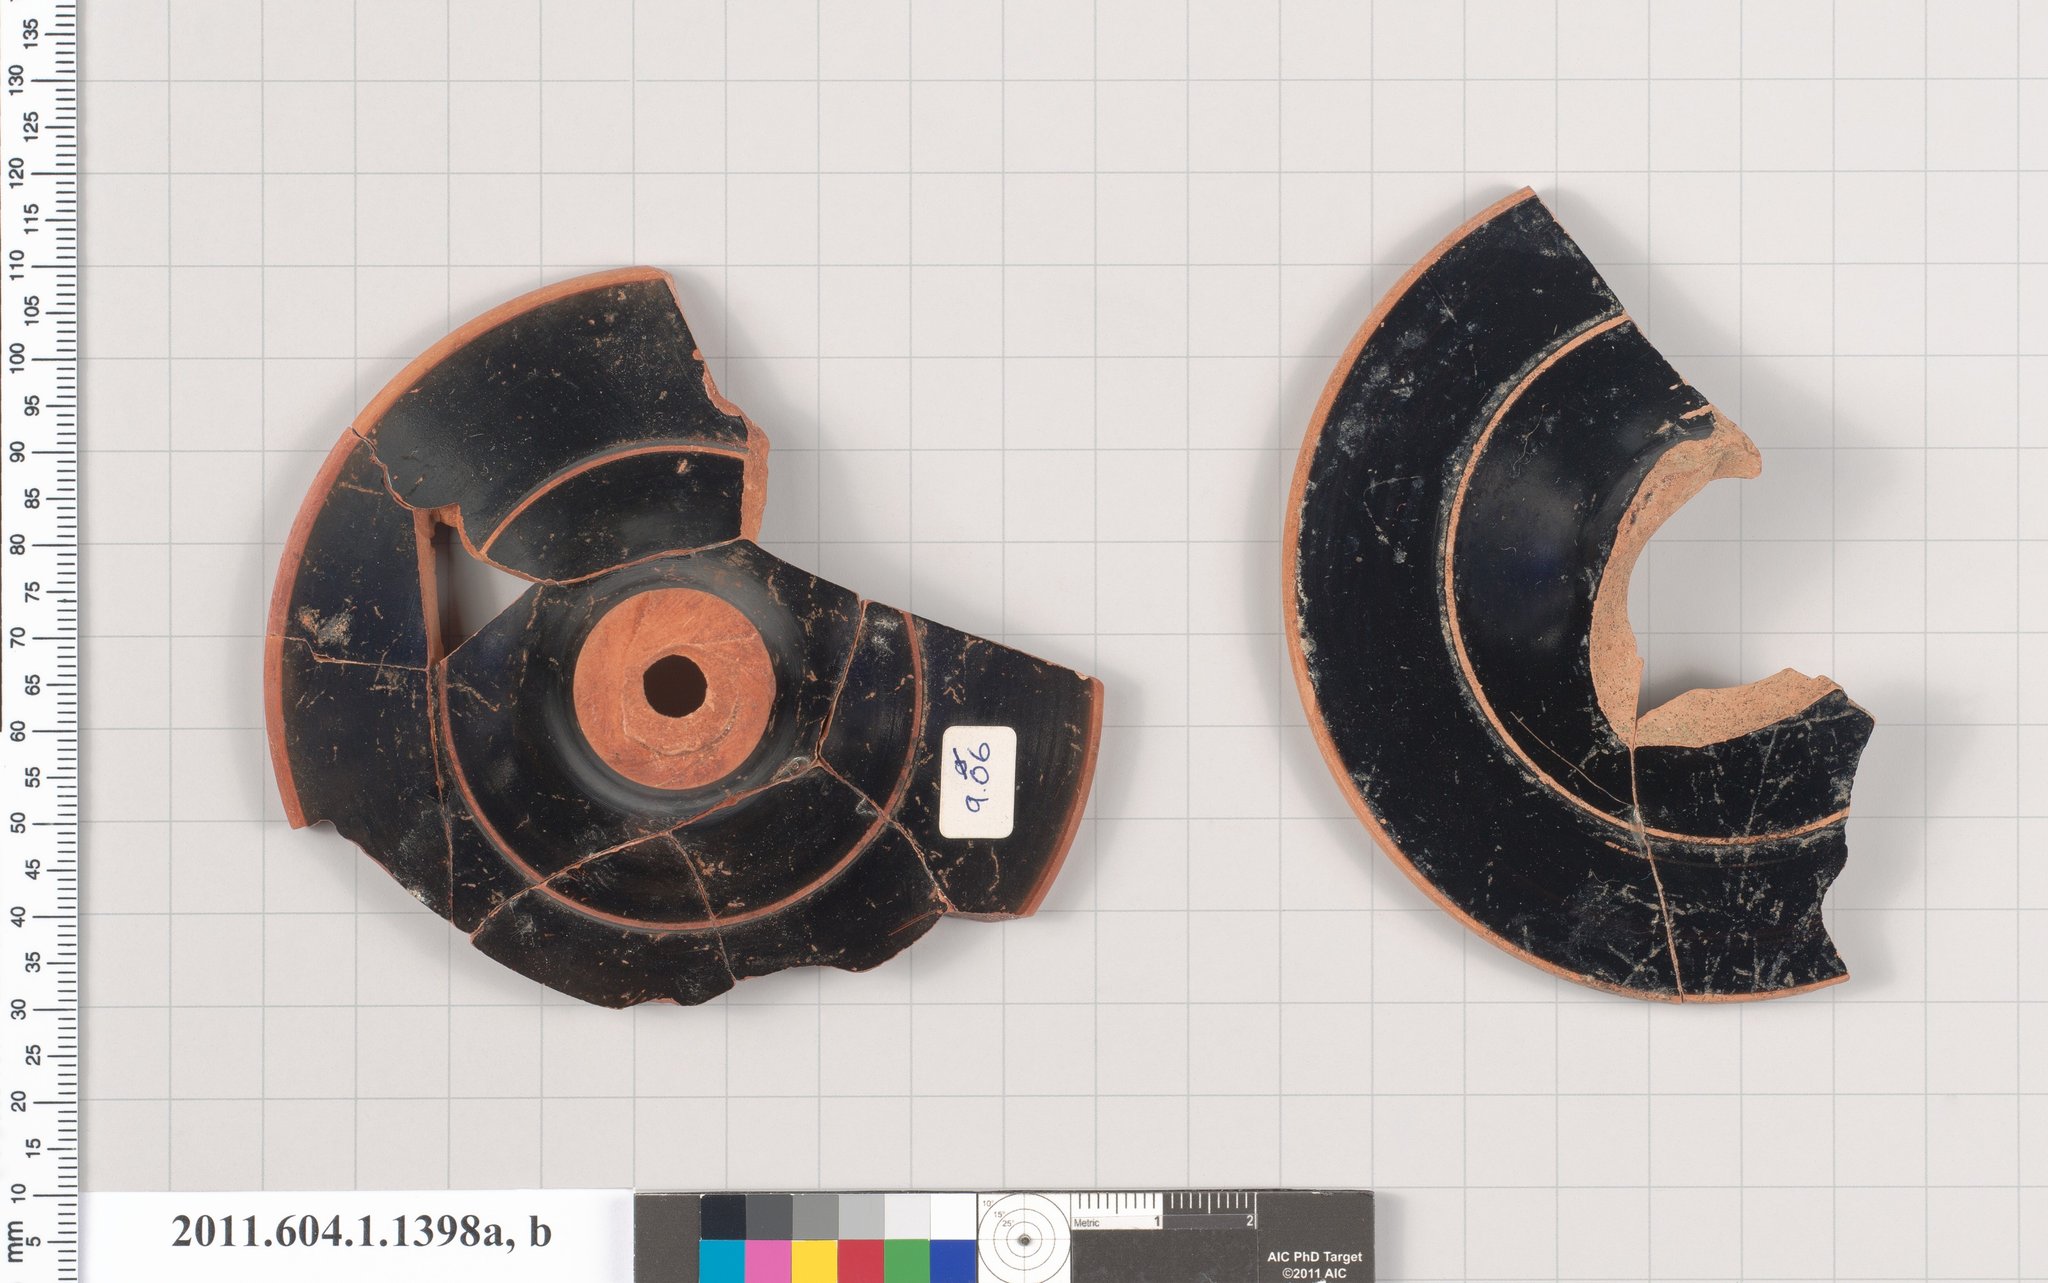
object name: kylix fragment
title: Terracotta fragments of kylikes (drinking cups)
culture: greek, attic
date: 500-401 BCE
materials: terracotta